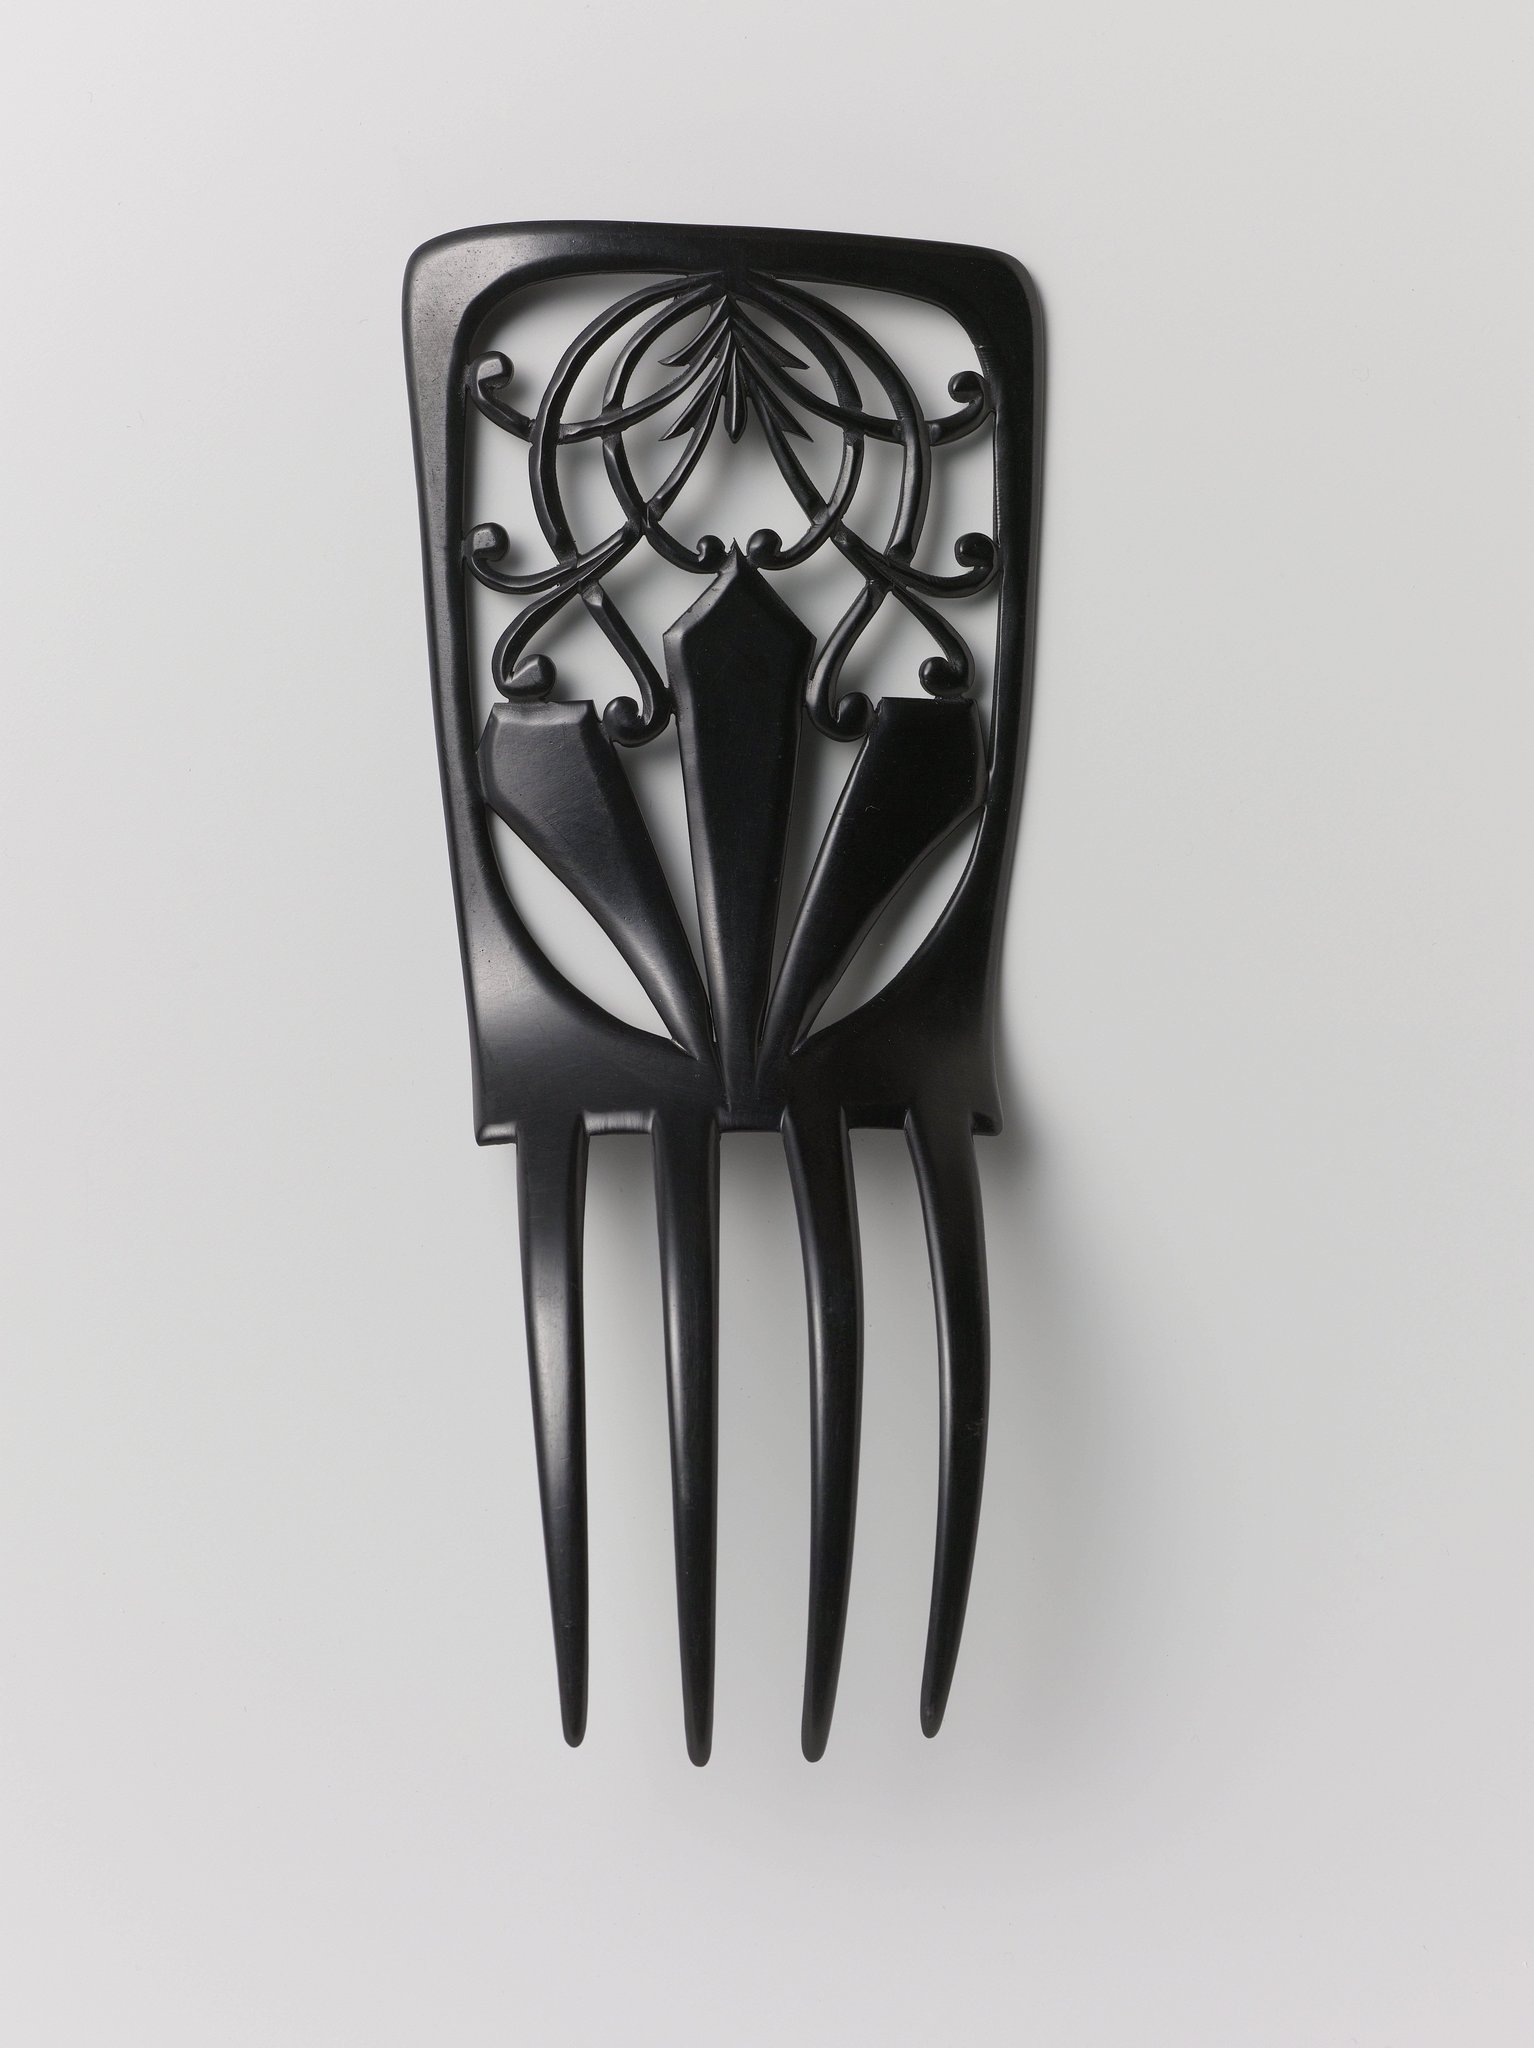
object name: comb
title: Haarkam van zwartgelakt hout met langwerpige rechthoekige ajour gesneden rug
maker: Anonymous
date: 1880-1920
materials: lacquer, wood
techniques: cutting, embroidery, lacquer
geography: amsterdam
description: Haarkam van zwartgelakt hout met langwerpige rechthoekige ajour gesneden rug met drie pijlvormen waarboven fijne sierlijke krullen. Vier tanden.